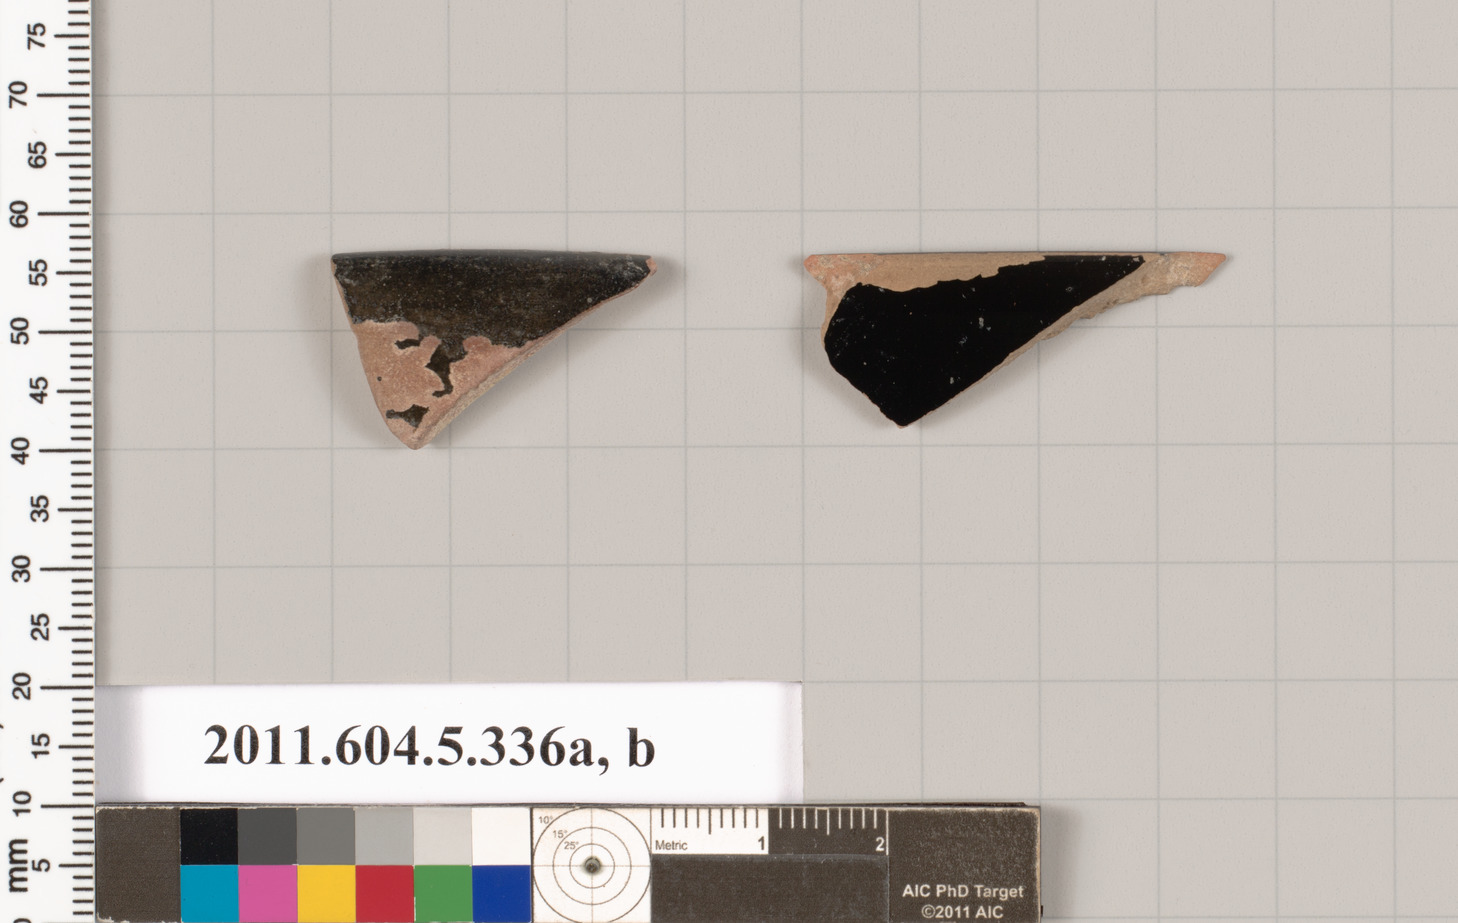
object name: kylix fragment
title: Terracotta rim fragments of kylikes (drinking cups)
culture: greek, attic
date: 600-401 BCE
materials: terracotta